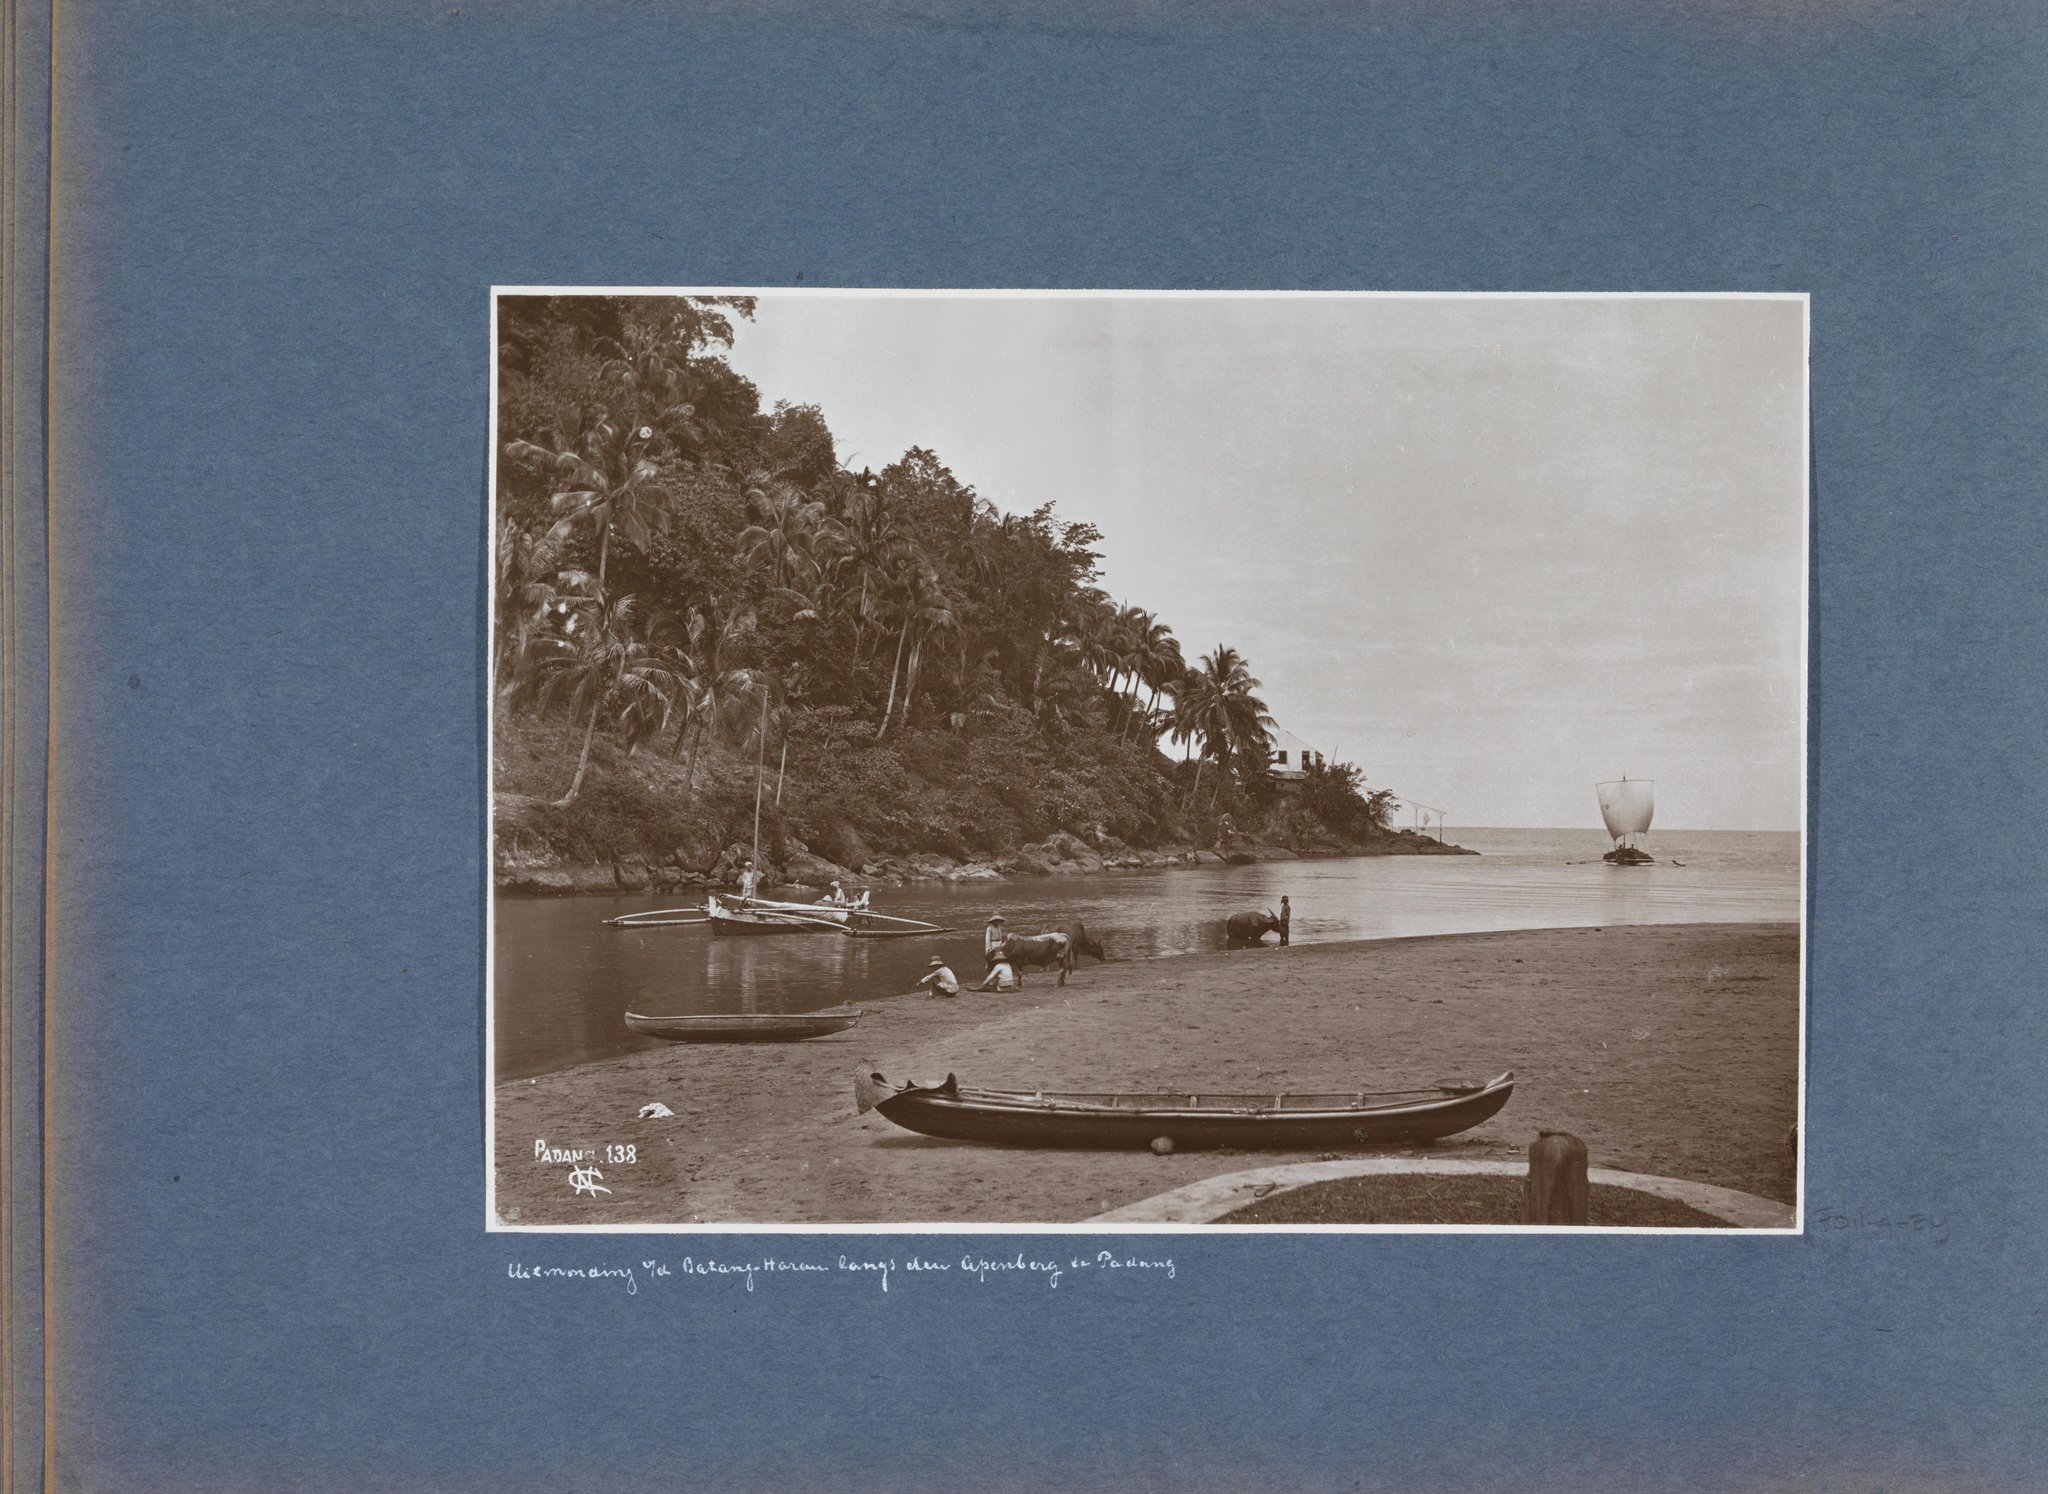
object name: album leaf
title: Uitmonding van de Batang Aron bij de Apenberg in Padang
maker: christiaan benjamin nieuwenhuis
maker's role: publisher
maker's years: 1863-1922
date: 1900-1920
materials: paper, photographic support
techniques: gelatin silver print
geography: padang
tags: harbour, river bank, rowing-boat, canoe, etc.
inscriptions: number: ‘138’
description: Onderdeel van reisalbum met foto's van bedrijvigheid en bezienswaardigheden op Sumatra en Java en van de reis naar en van Nederlands-Indië.